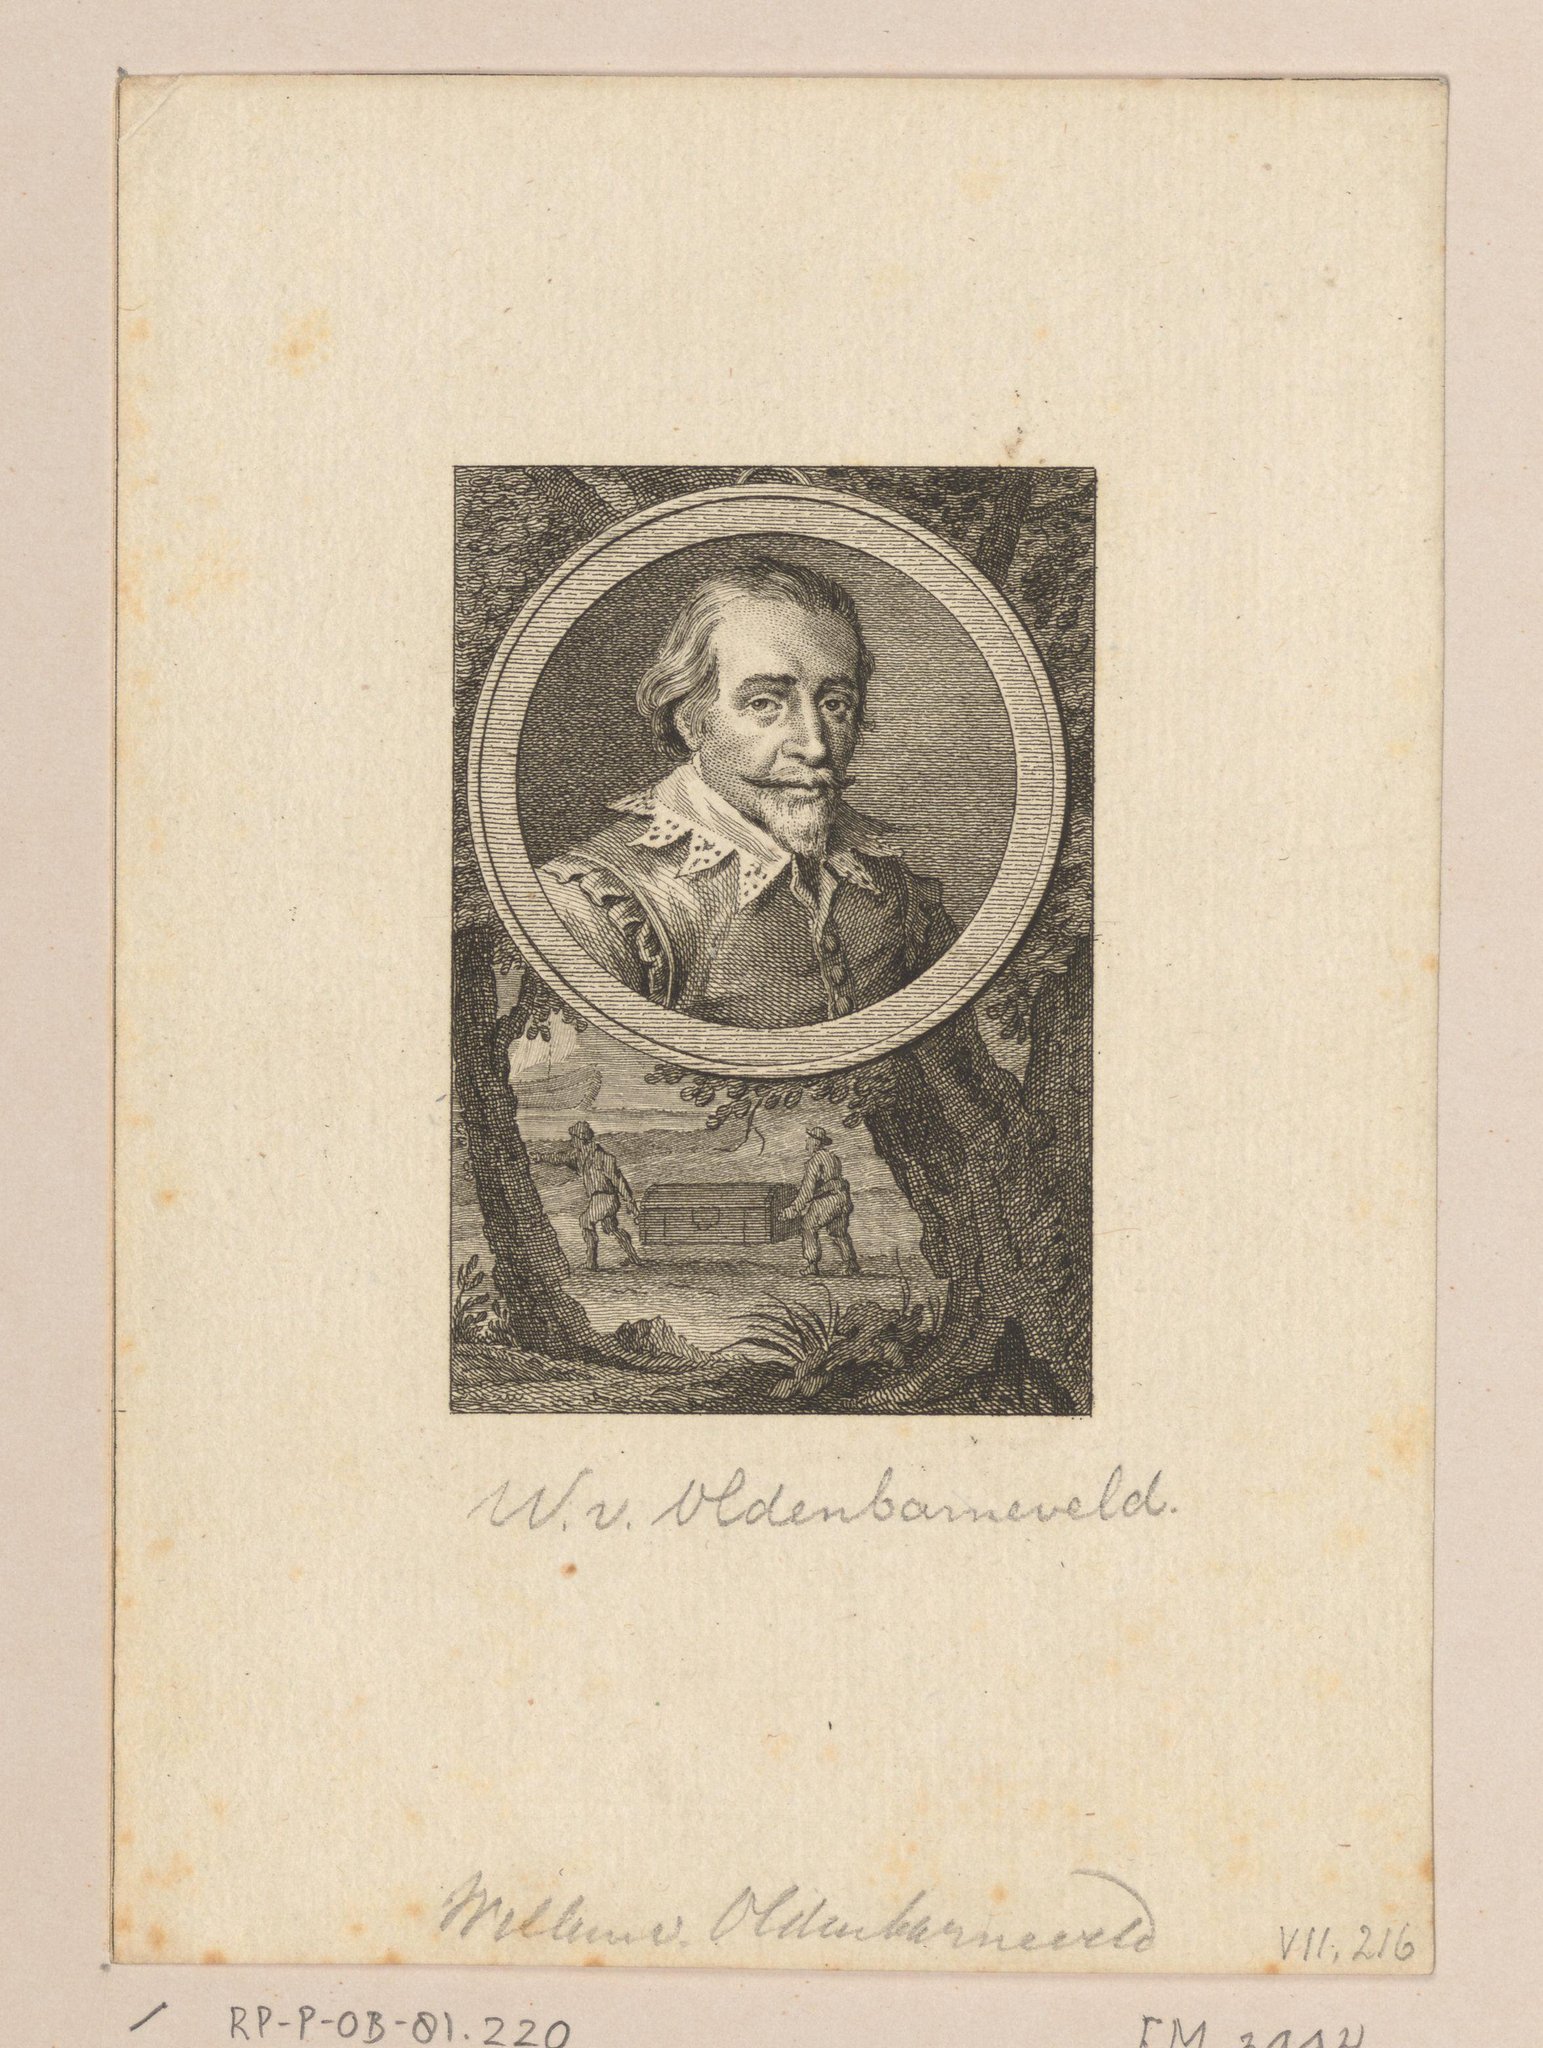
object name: print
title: Portret van Willem van Oldenbarnevelt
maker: reinier vinkeles (i)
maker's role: draughtsman, print maker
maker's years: 1741-1816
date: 1751-1816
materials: paper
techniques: etching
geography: northern netherlands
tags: maurice (prince of orange), the hague, brussels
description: Rond portret van Willem van Oldenbarnevelt, op de achtergrond dragen twee mannen een kist,